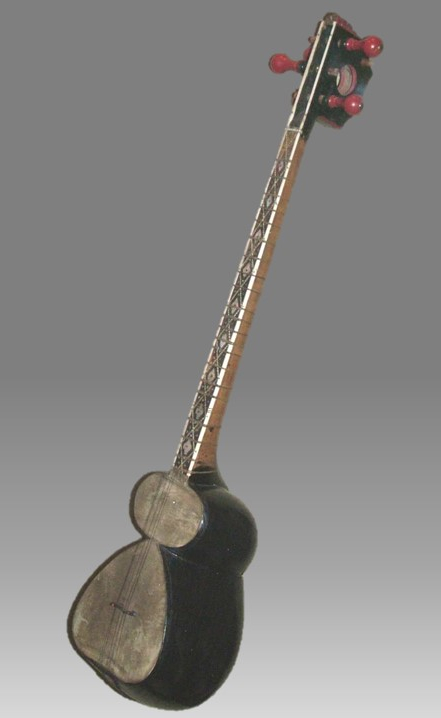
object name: tar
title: Tār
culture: georgian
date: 1867-1900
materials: ivory, skin, wood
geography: georgia